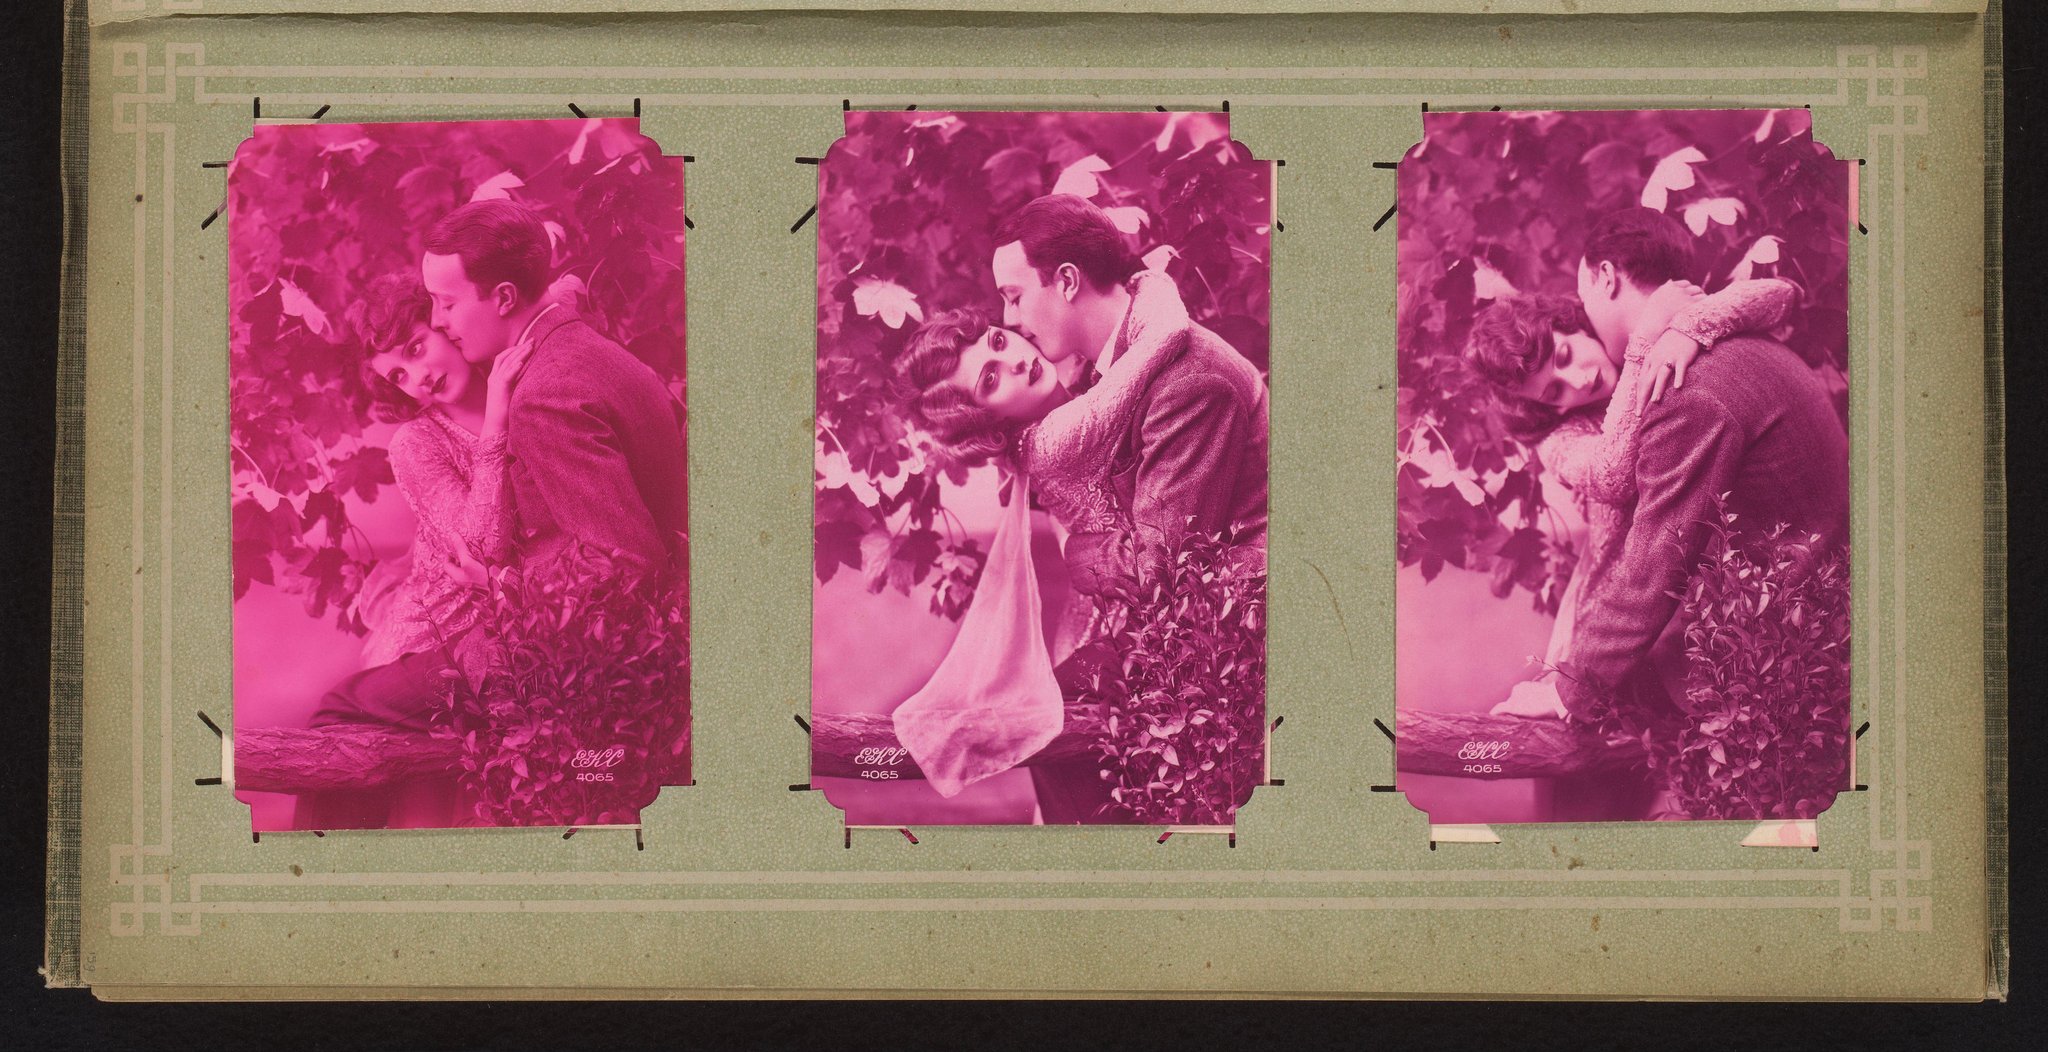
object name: album leaf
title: Drie portretten van een paar geliefden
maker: Anonymous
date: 1900-1930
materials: cardboard, photographic support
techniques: gelatin silver print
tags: historical persons - bb - woman, historical persons, couple of lovers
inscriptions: monogram: ‘EKC’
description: Deze foto's maken deel uit van een album.